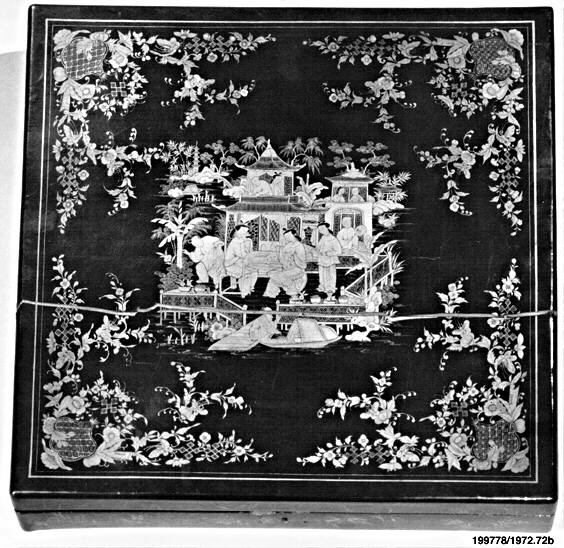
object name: box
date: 1834-1866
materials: cardboard, paper, textile, silk, wood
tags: men,flowers,boats